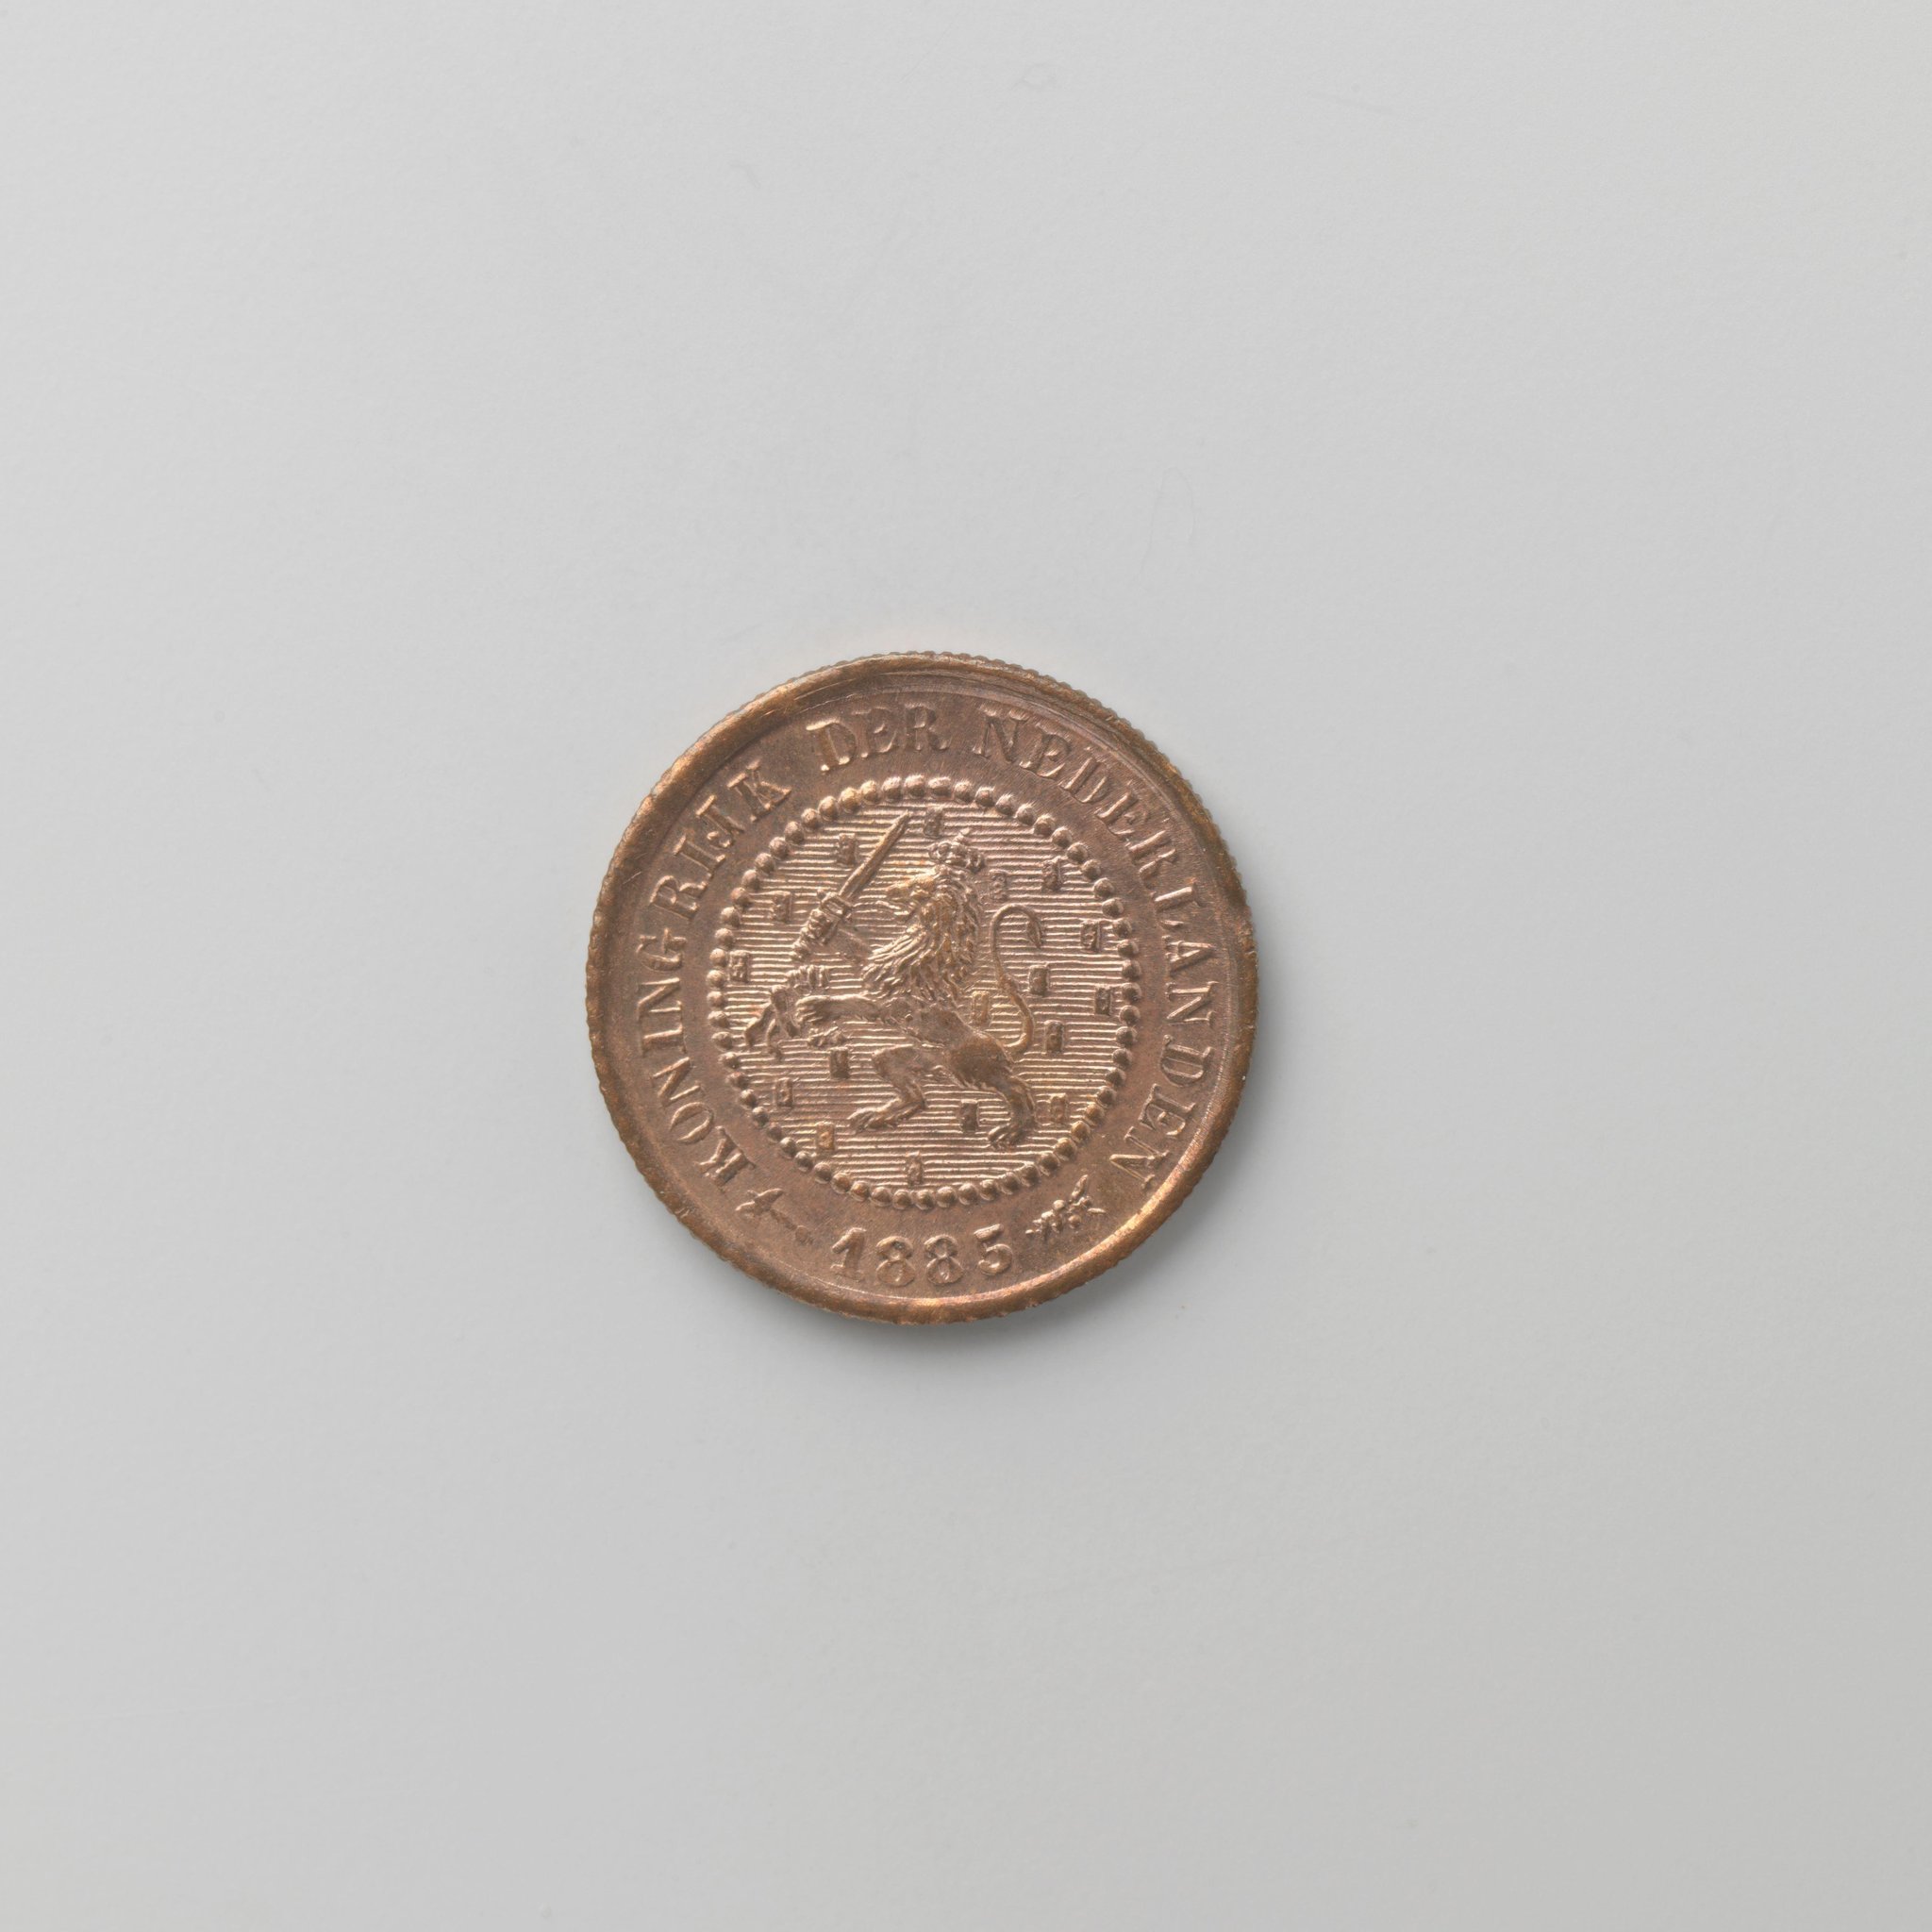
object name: coin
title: Nederland, ½ cent, 1885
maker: willem iii (koning der nederlanden)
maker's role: koning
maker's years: 1817-1890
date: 1885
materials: bronze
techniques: striking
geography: utrecht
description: Bronzen munt. Voorzijde: in een veld rijkswapen. Jaartal onderaan in omschrift. Keerzijde: binnen twee samengebonden oranjetakken waarde-aanduiding ½ cent. Kartelrand.